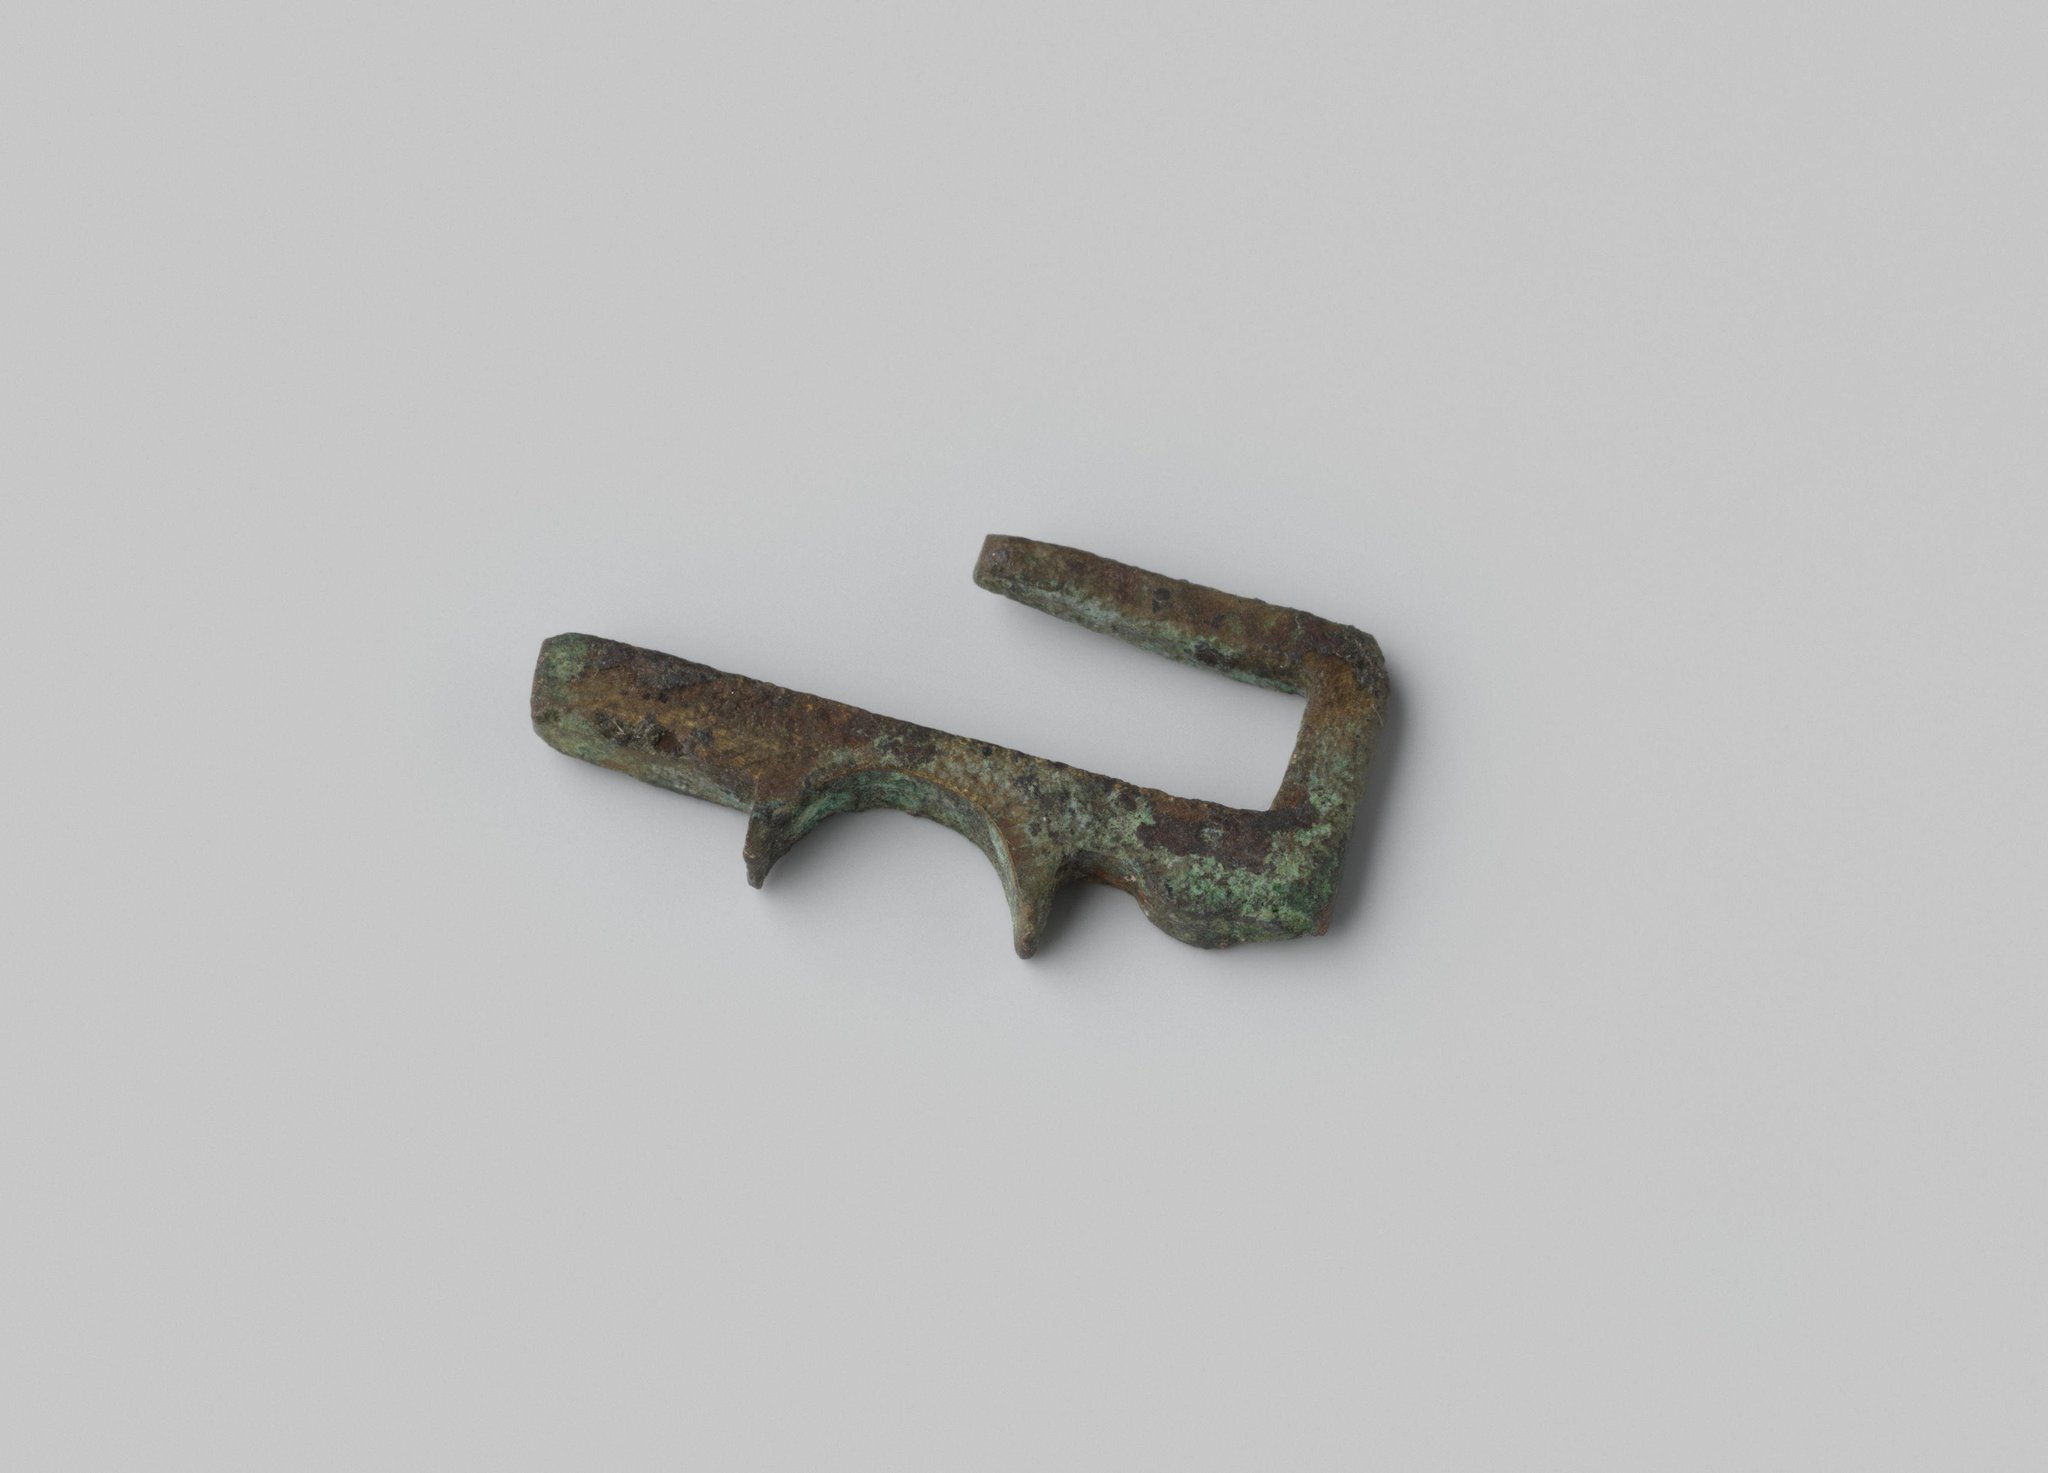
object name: lock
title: Deel van mechanisch gedeelte van een slot uit het wrak van de Oost-Indiëvaarder Hollandia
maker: Anonymous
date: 1700-1743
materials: copper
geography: netherlands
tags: verenigde oostindische compagnie, hollandia (schip), annet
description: Locks, fastenings and accessories. thumbler, small bar, tapering, rectangular curve, wavy moulding with 2 pointed projections on one side.